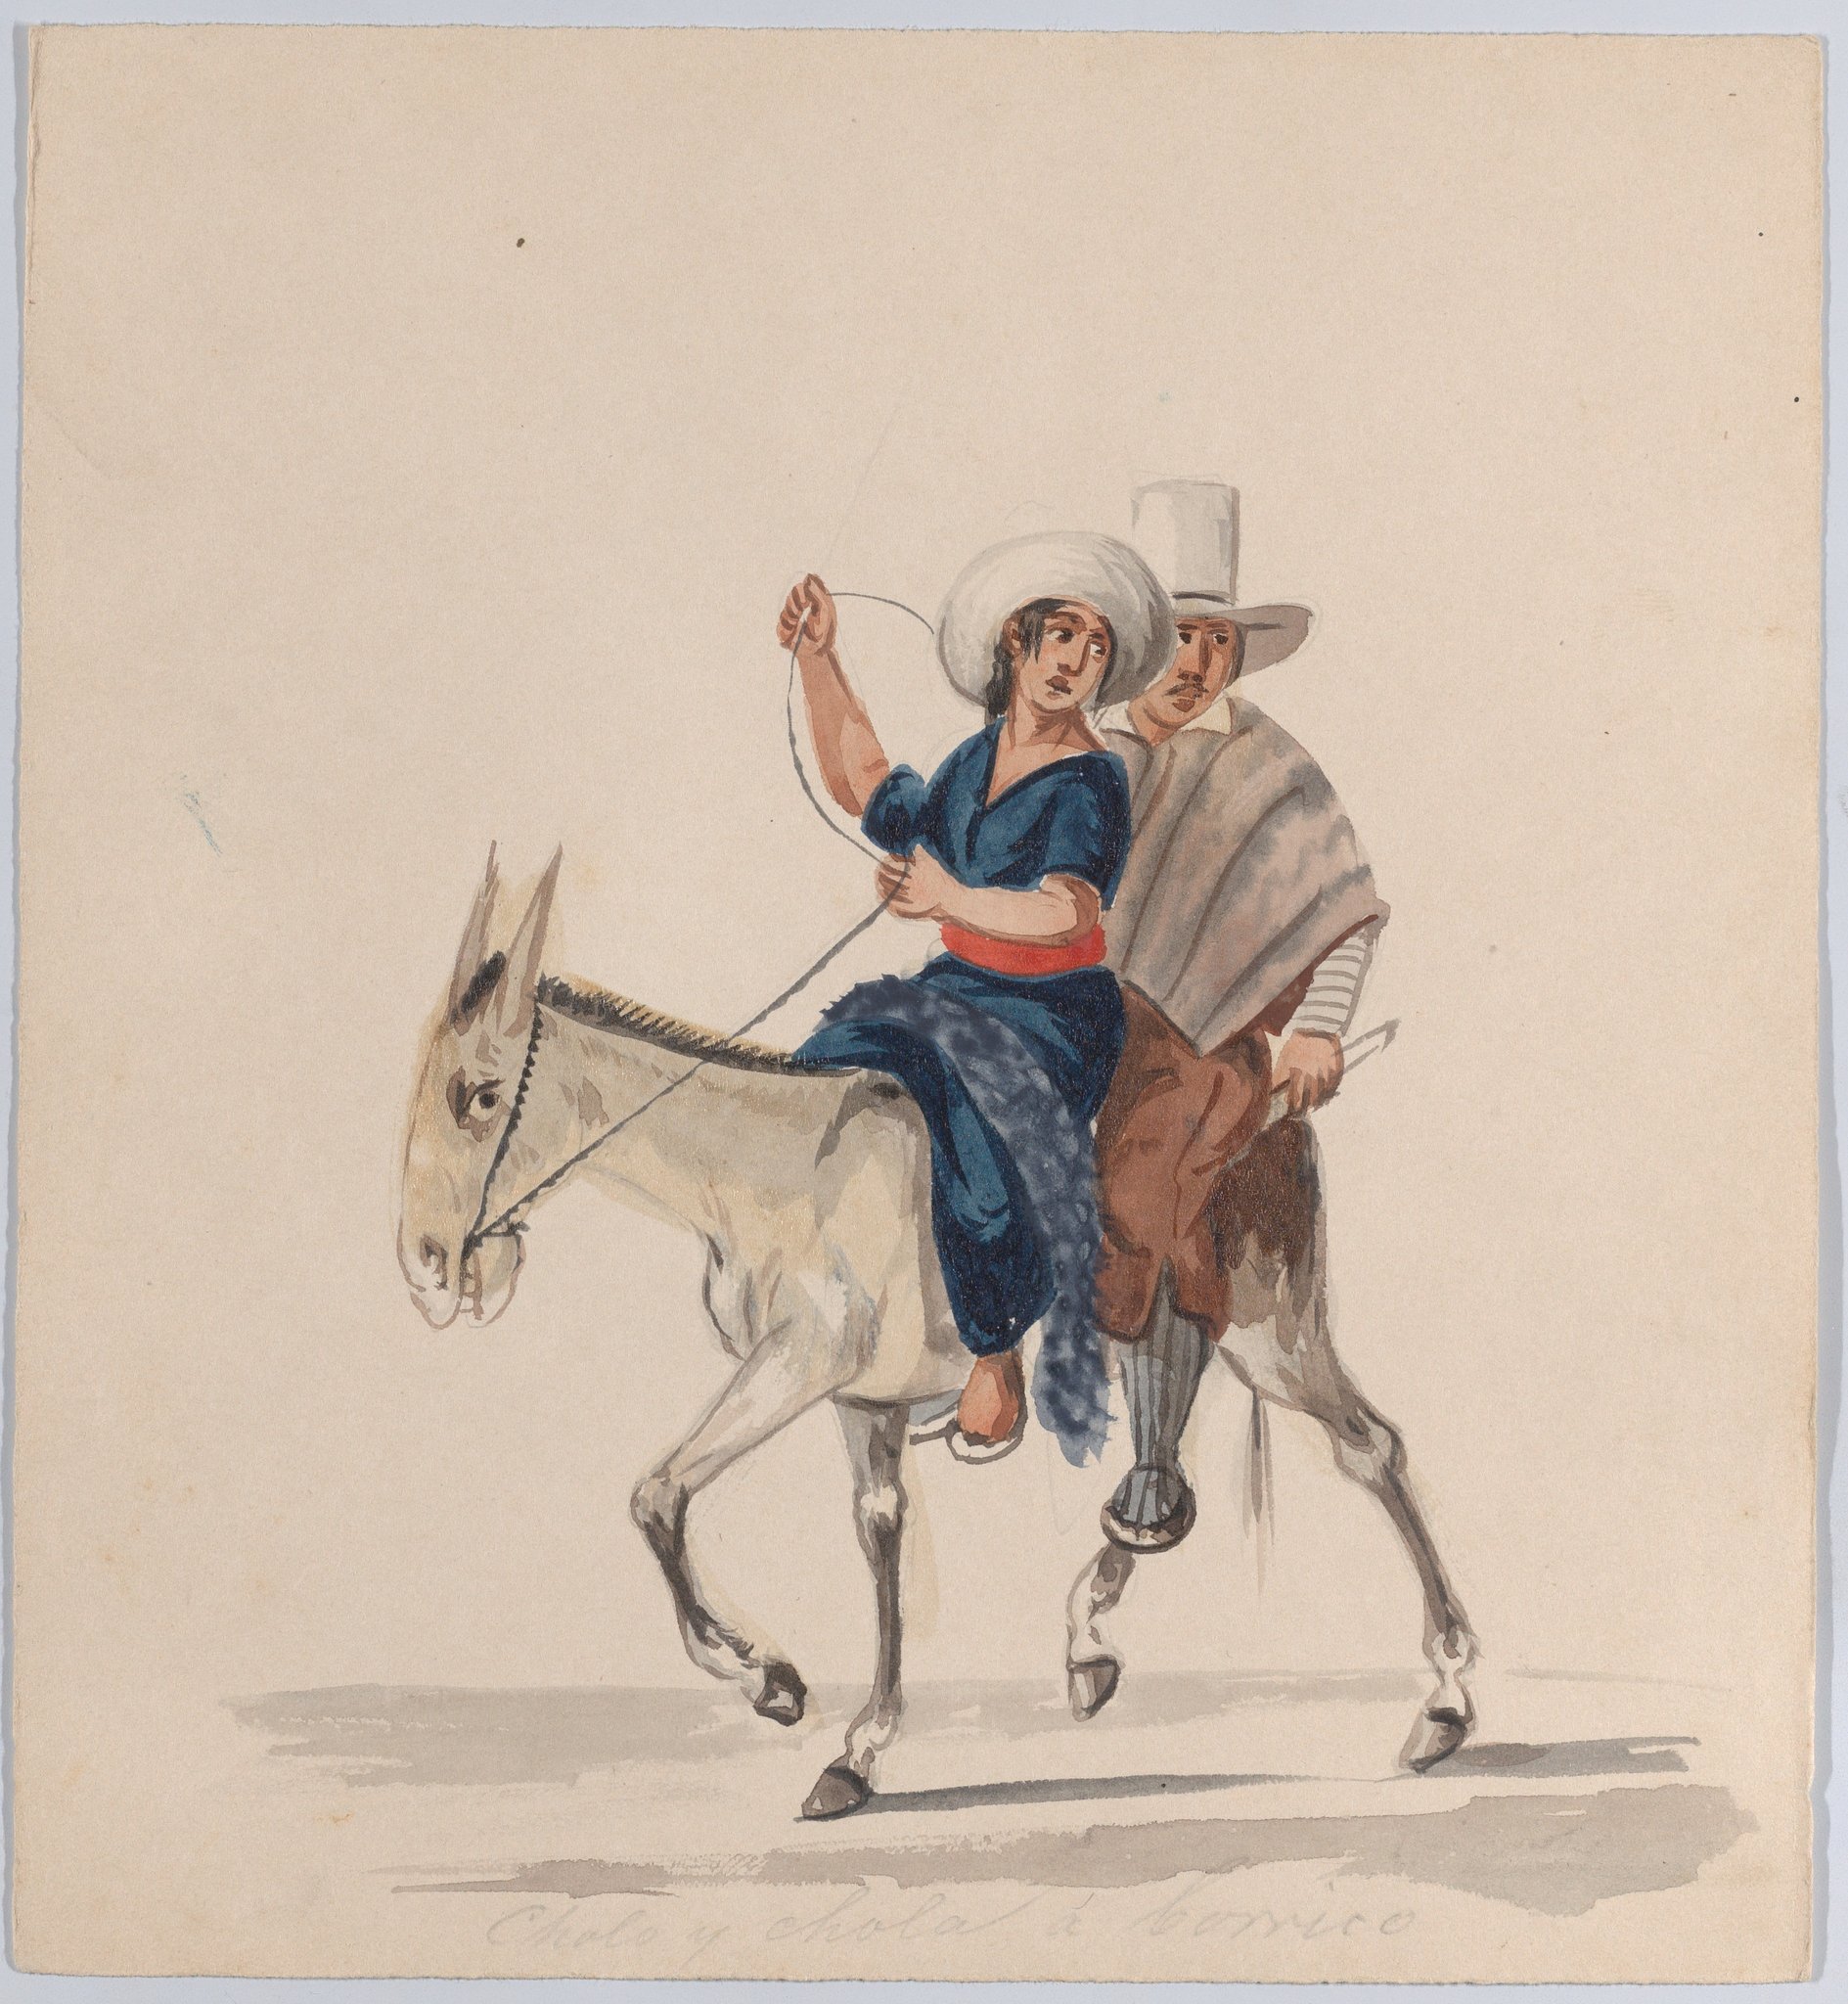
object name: drawing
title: An indigenous man and woman together riding a donkey; from a group of drawings depicting Peruvian dress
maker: francisco (pancho) fierro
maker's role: artist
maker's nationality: african peruvian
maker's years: 1807-1879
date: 1848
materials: watercolor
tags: men,women